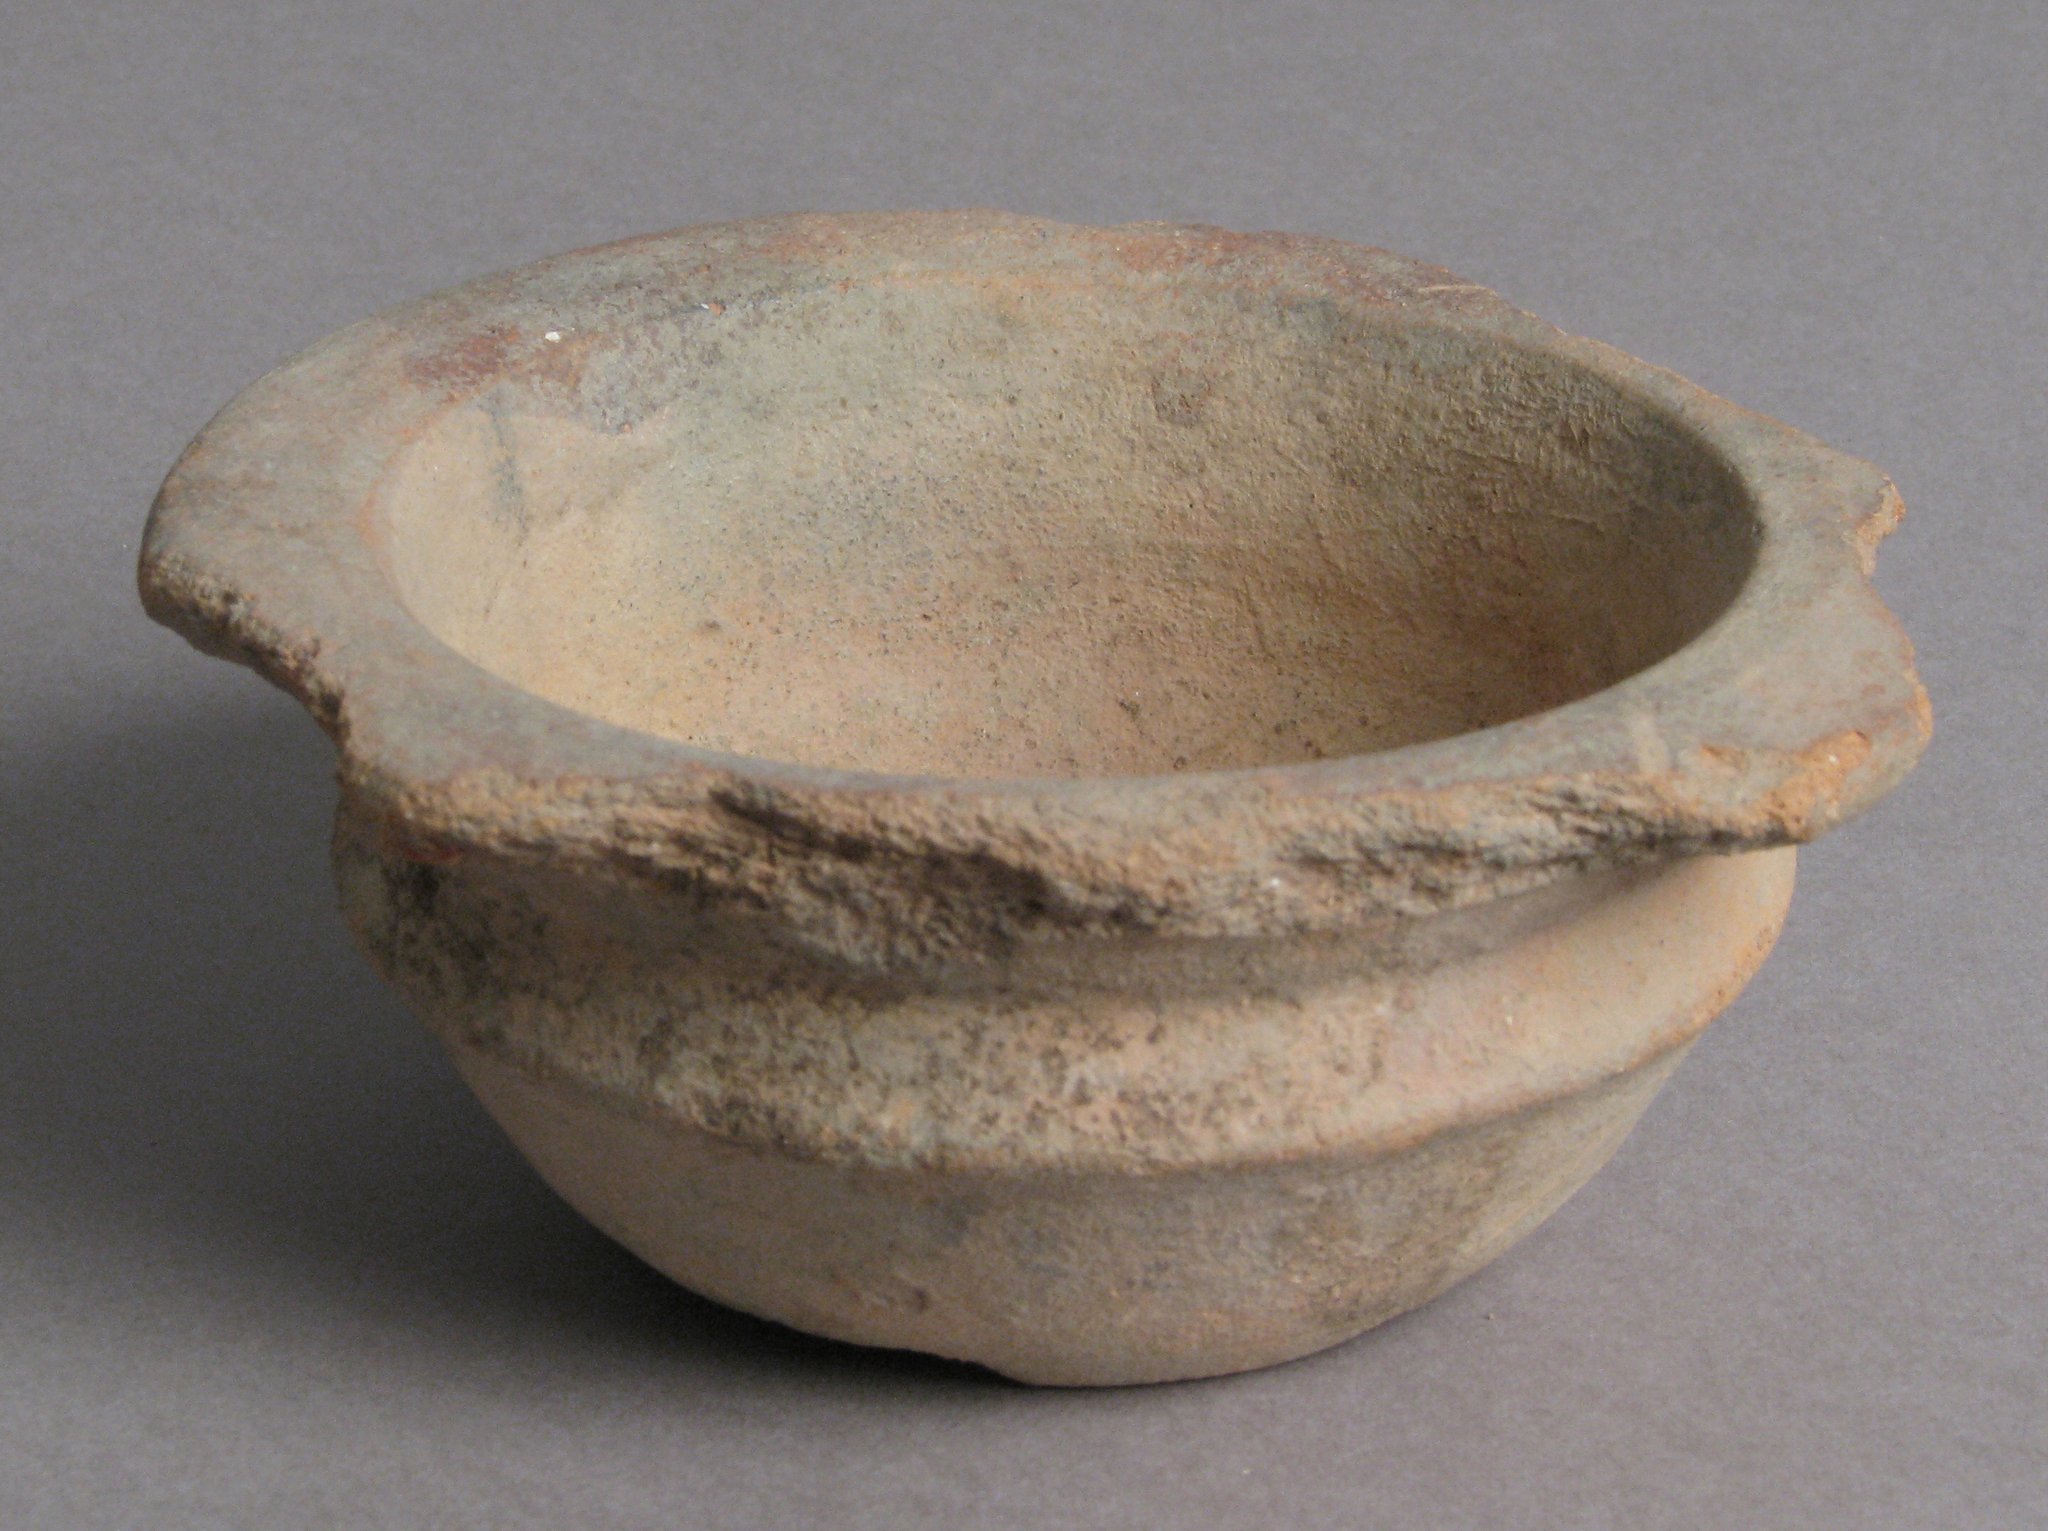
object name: bowl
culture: coptic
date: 301-700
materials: earthenware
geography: egypt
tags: bowls